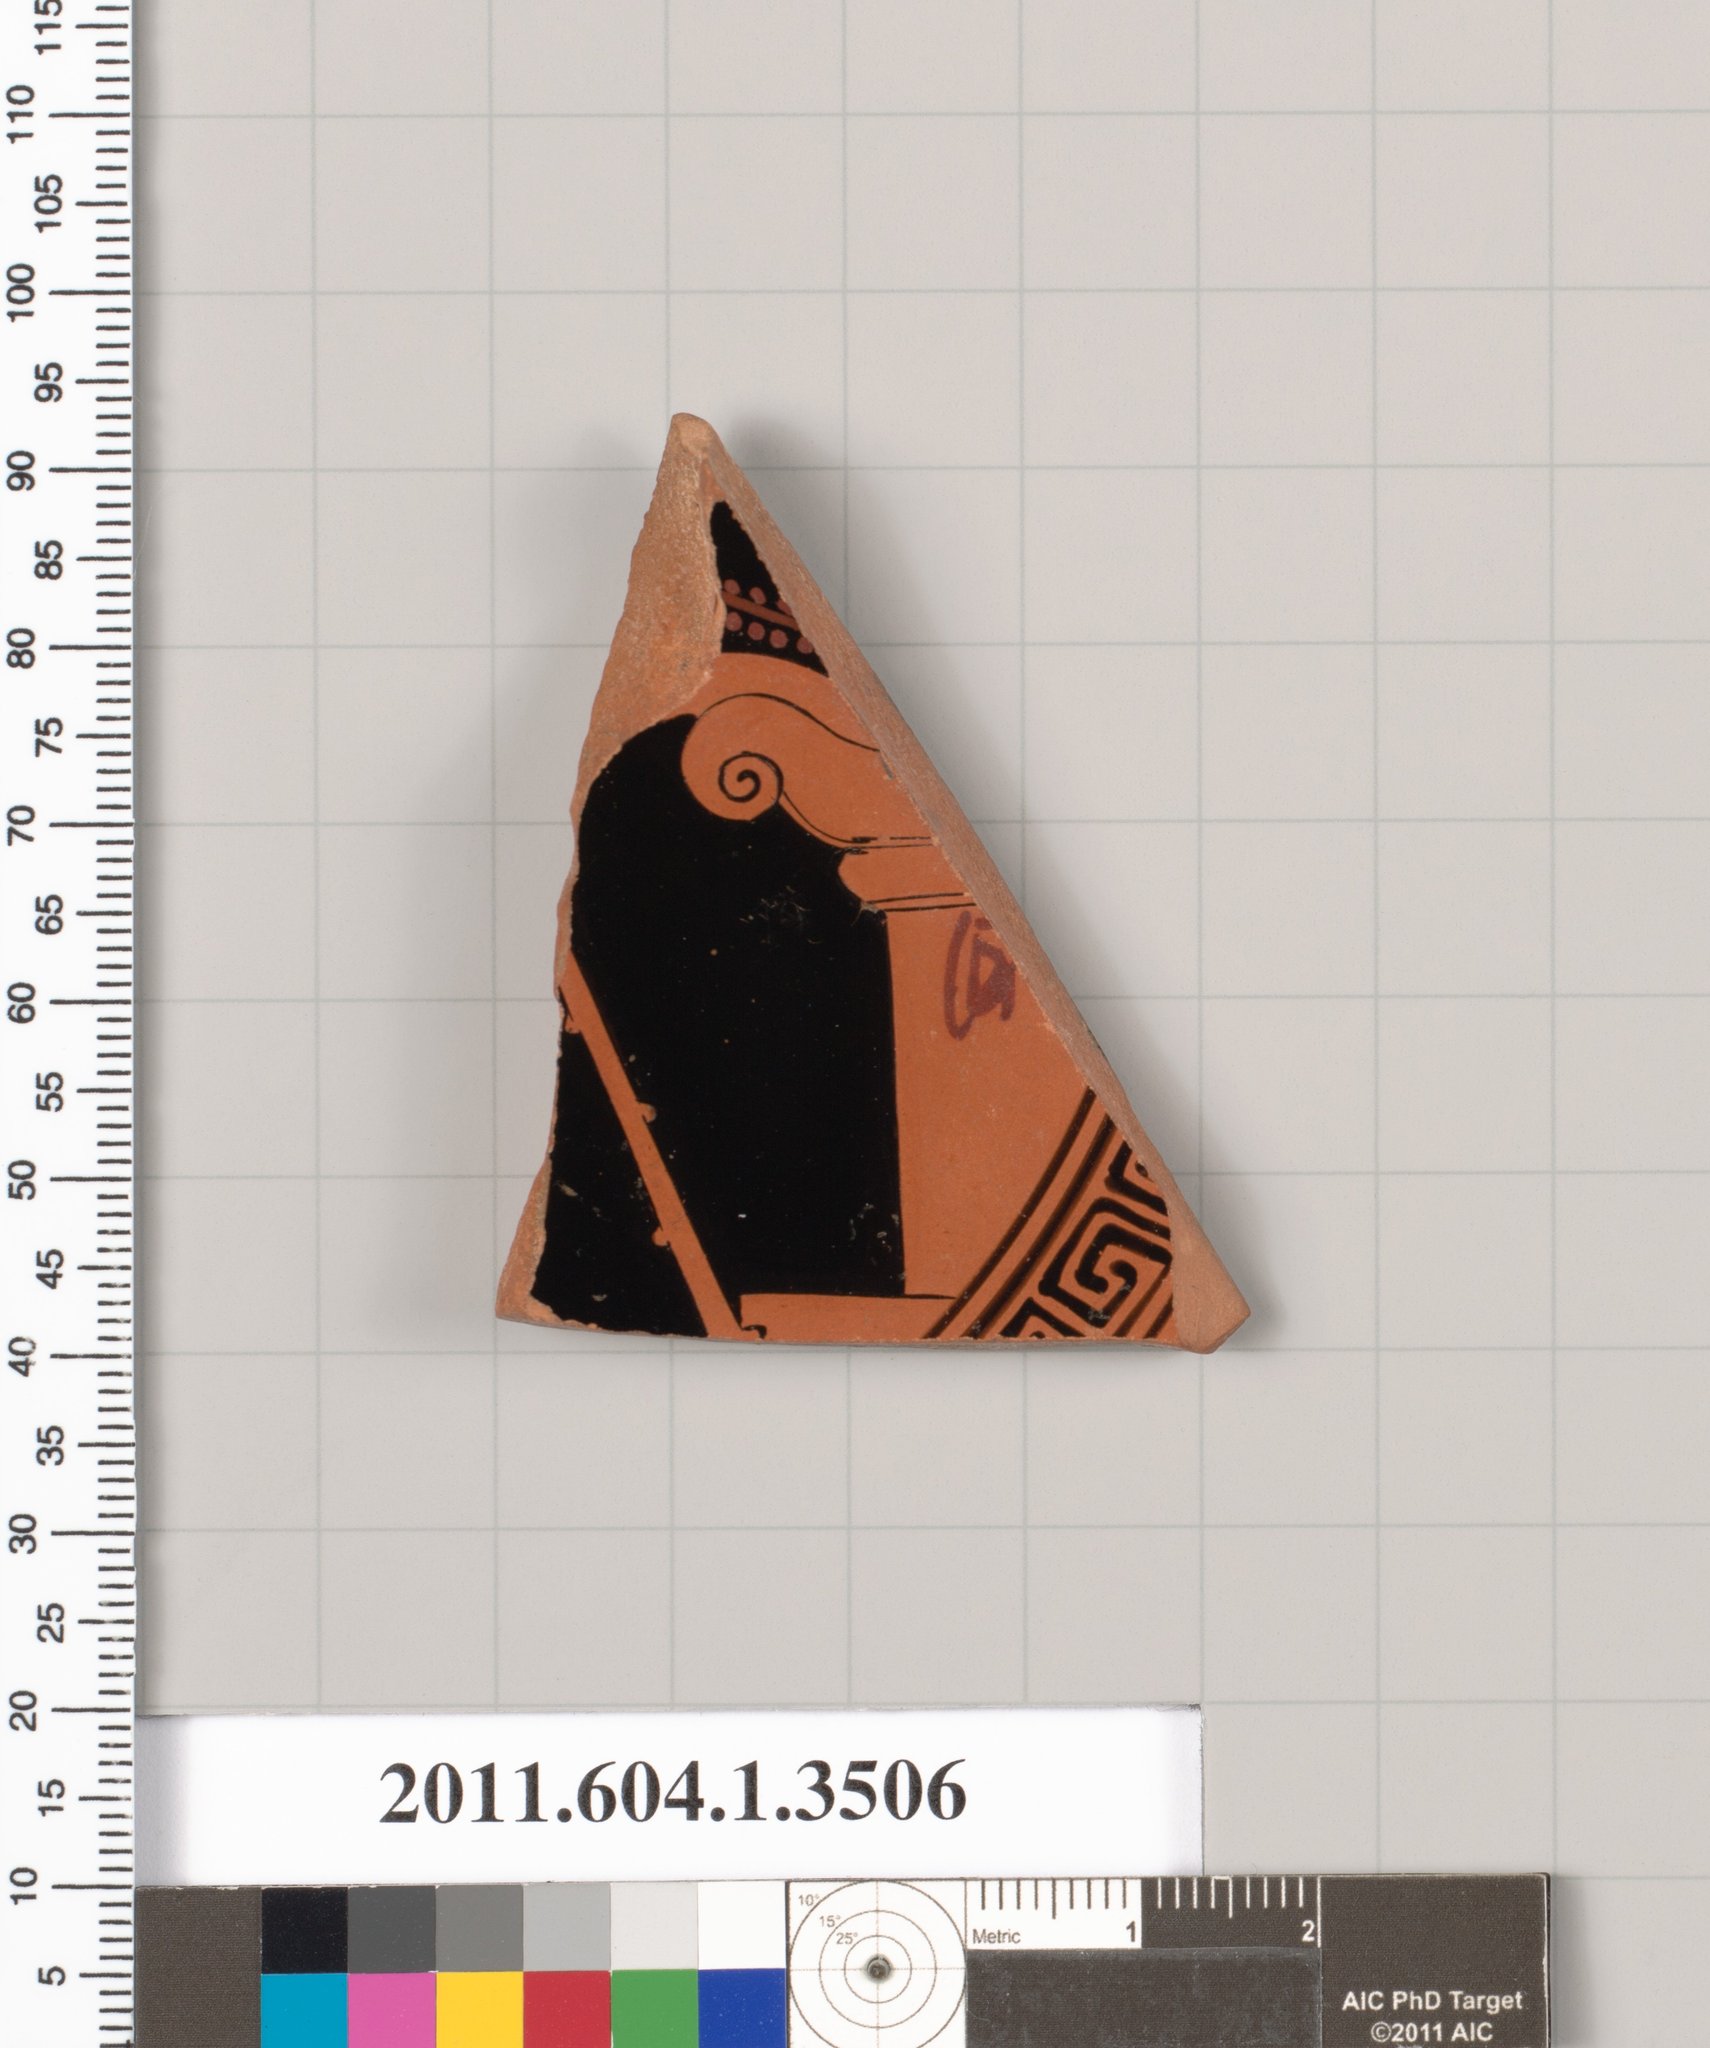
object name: kylix fragment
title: Terracotta fragment of a kylix (drinking cup)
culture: greek, attic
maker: makron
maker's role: artist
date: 490-480 BCE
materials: terracotta